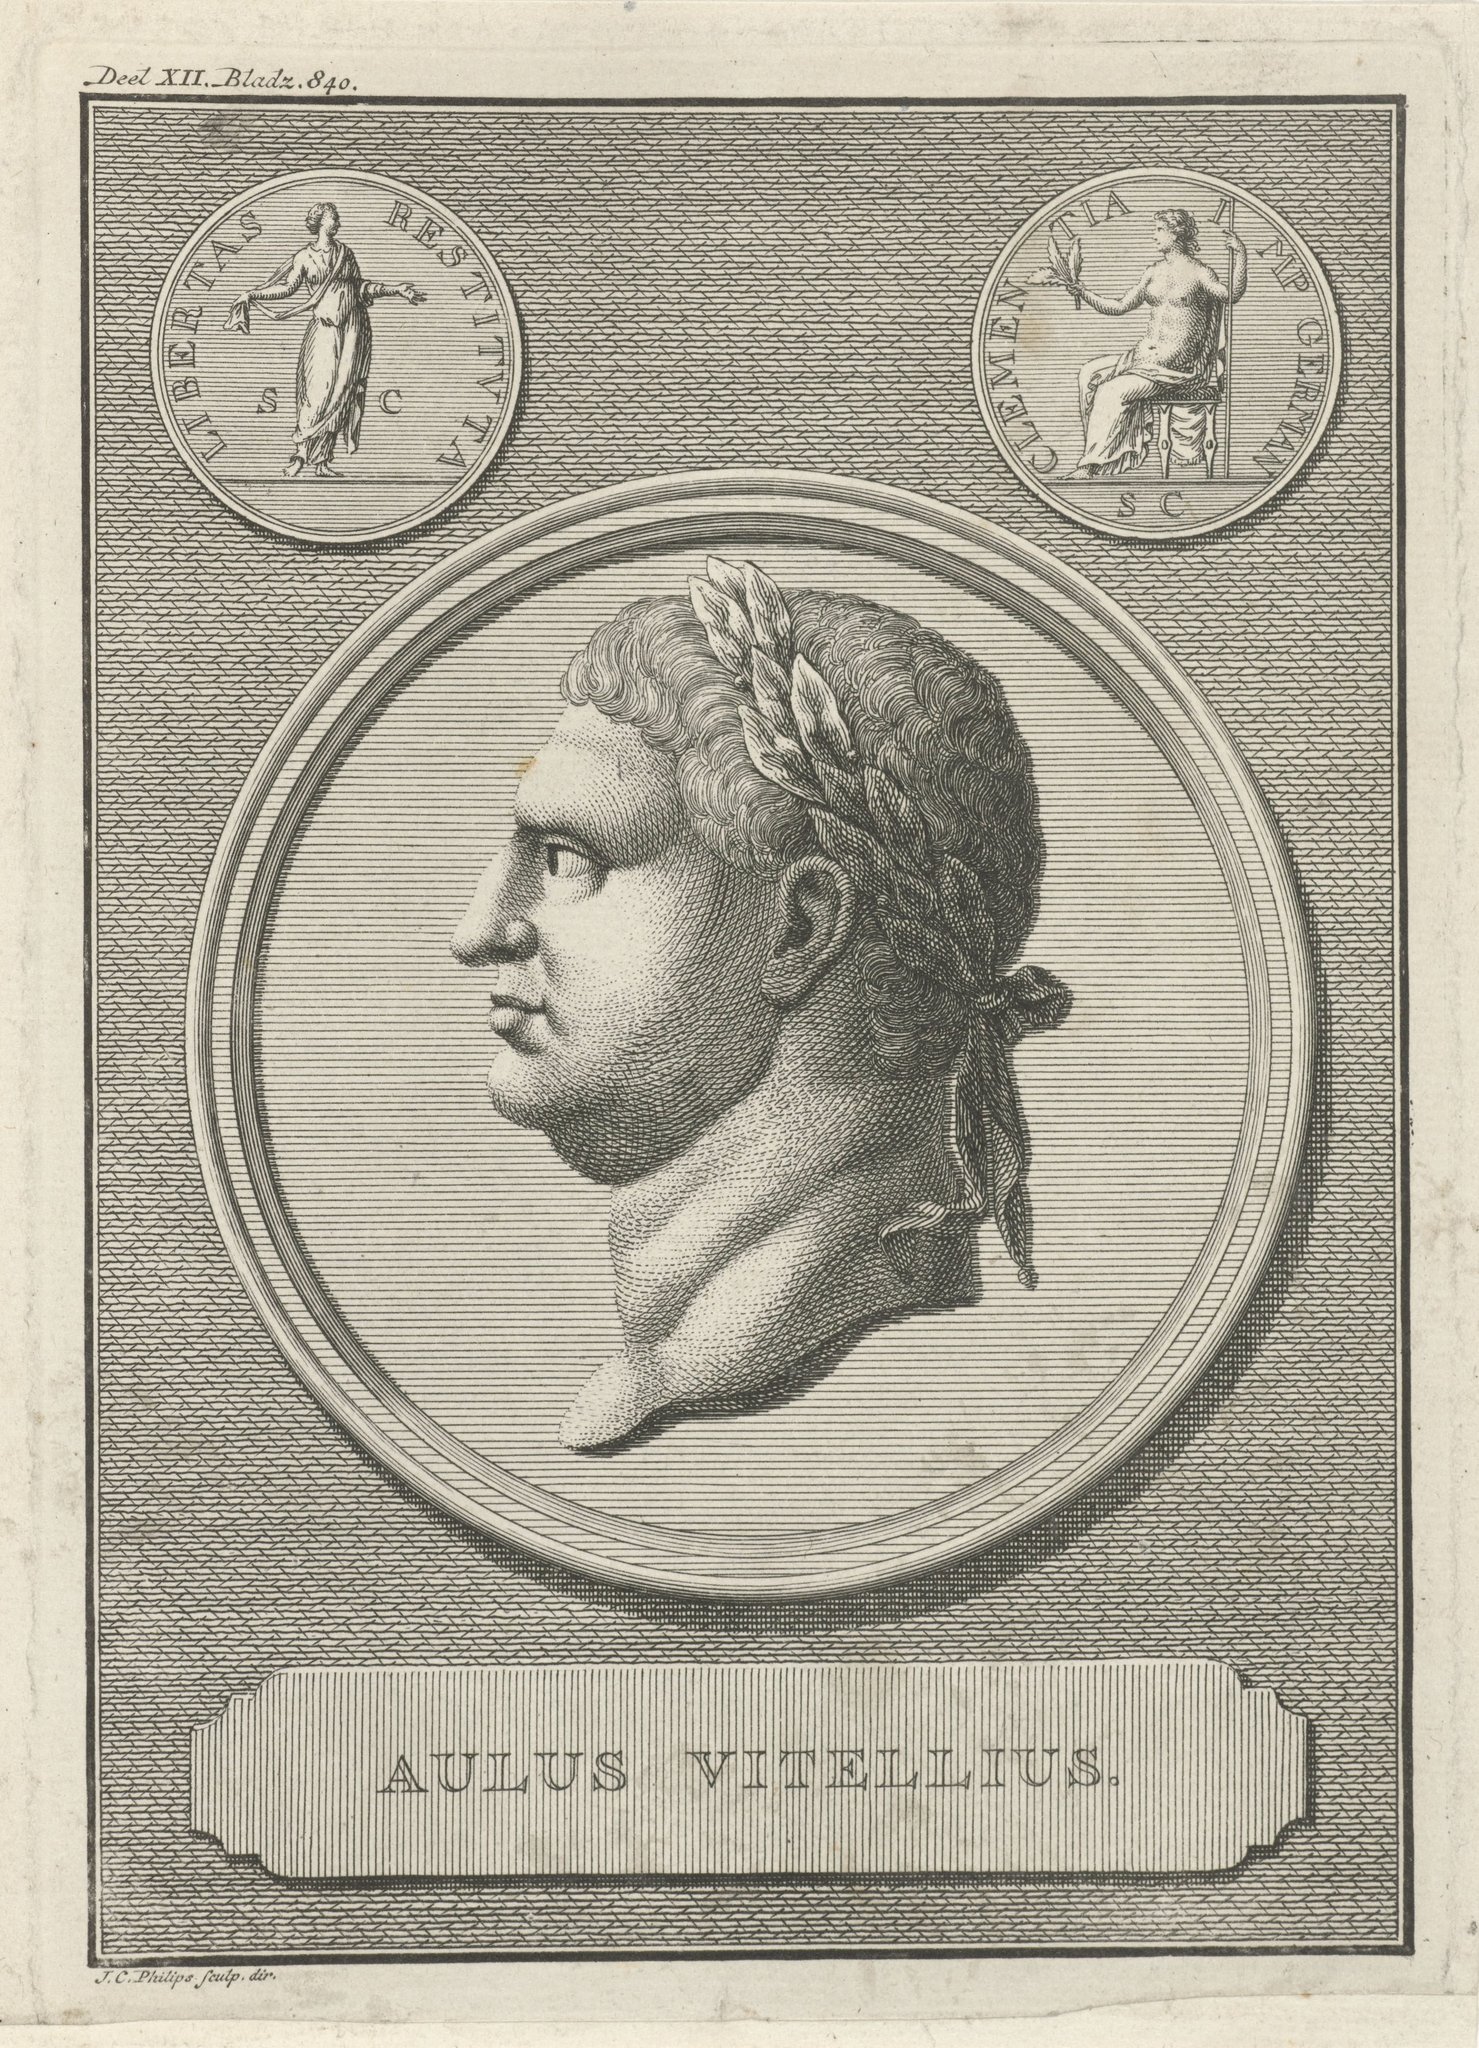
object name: print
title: Portret van keizer Vitellius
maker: jan caspar philips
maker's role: draughtsman, print maker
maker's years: 1700-1775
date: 1746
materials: paper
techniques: engraving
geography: amsterdam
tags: coin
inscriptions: collector's mark: Lugt 2228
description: Prent gebruikt als illustratie in: Westerbaen, Kornelis, Algemeene histori van het begin der wereld af tot den tegenwoordigen tijd toe, deel XII. Utrecht: Herman Besseling, 1746.